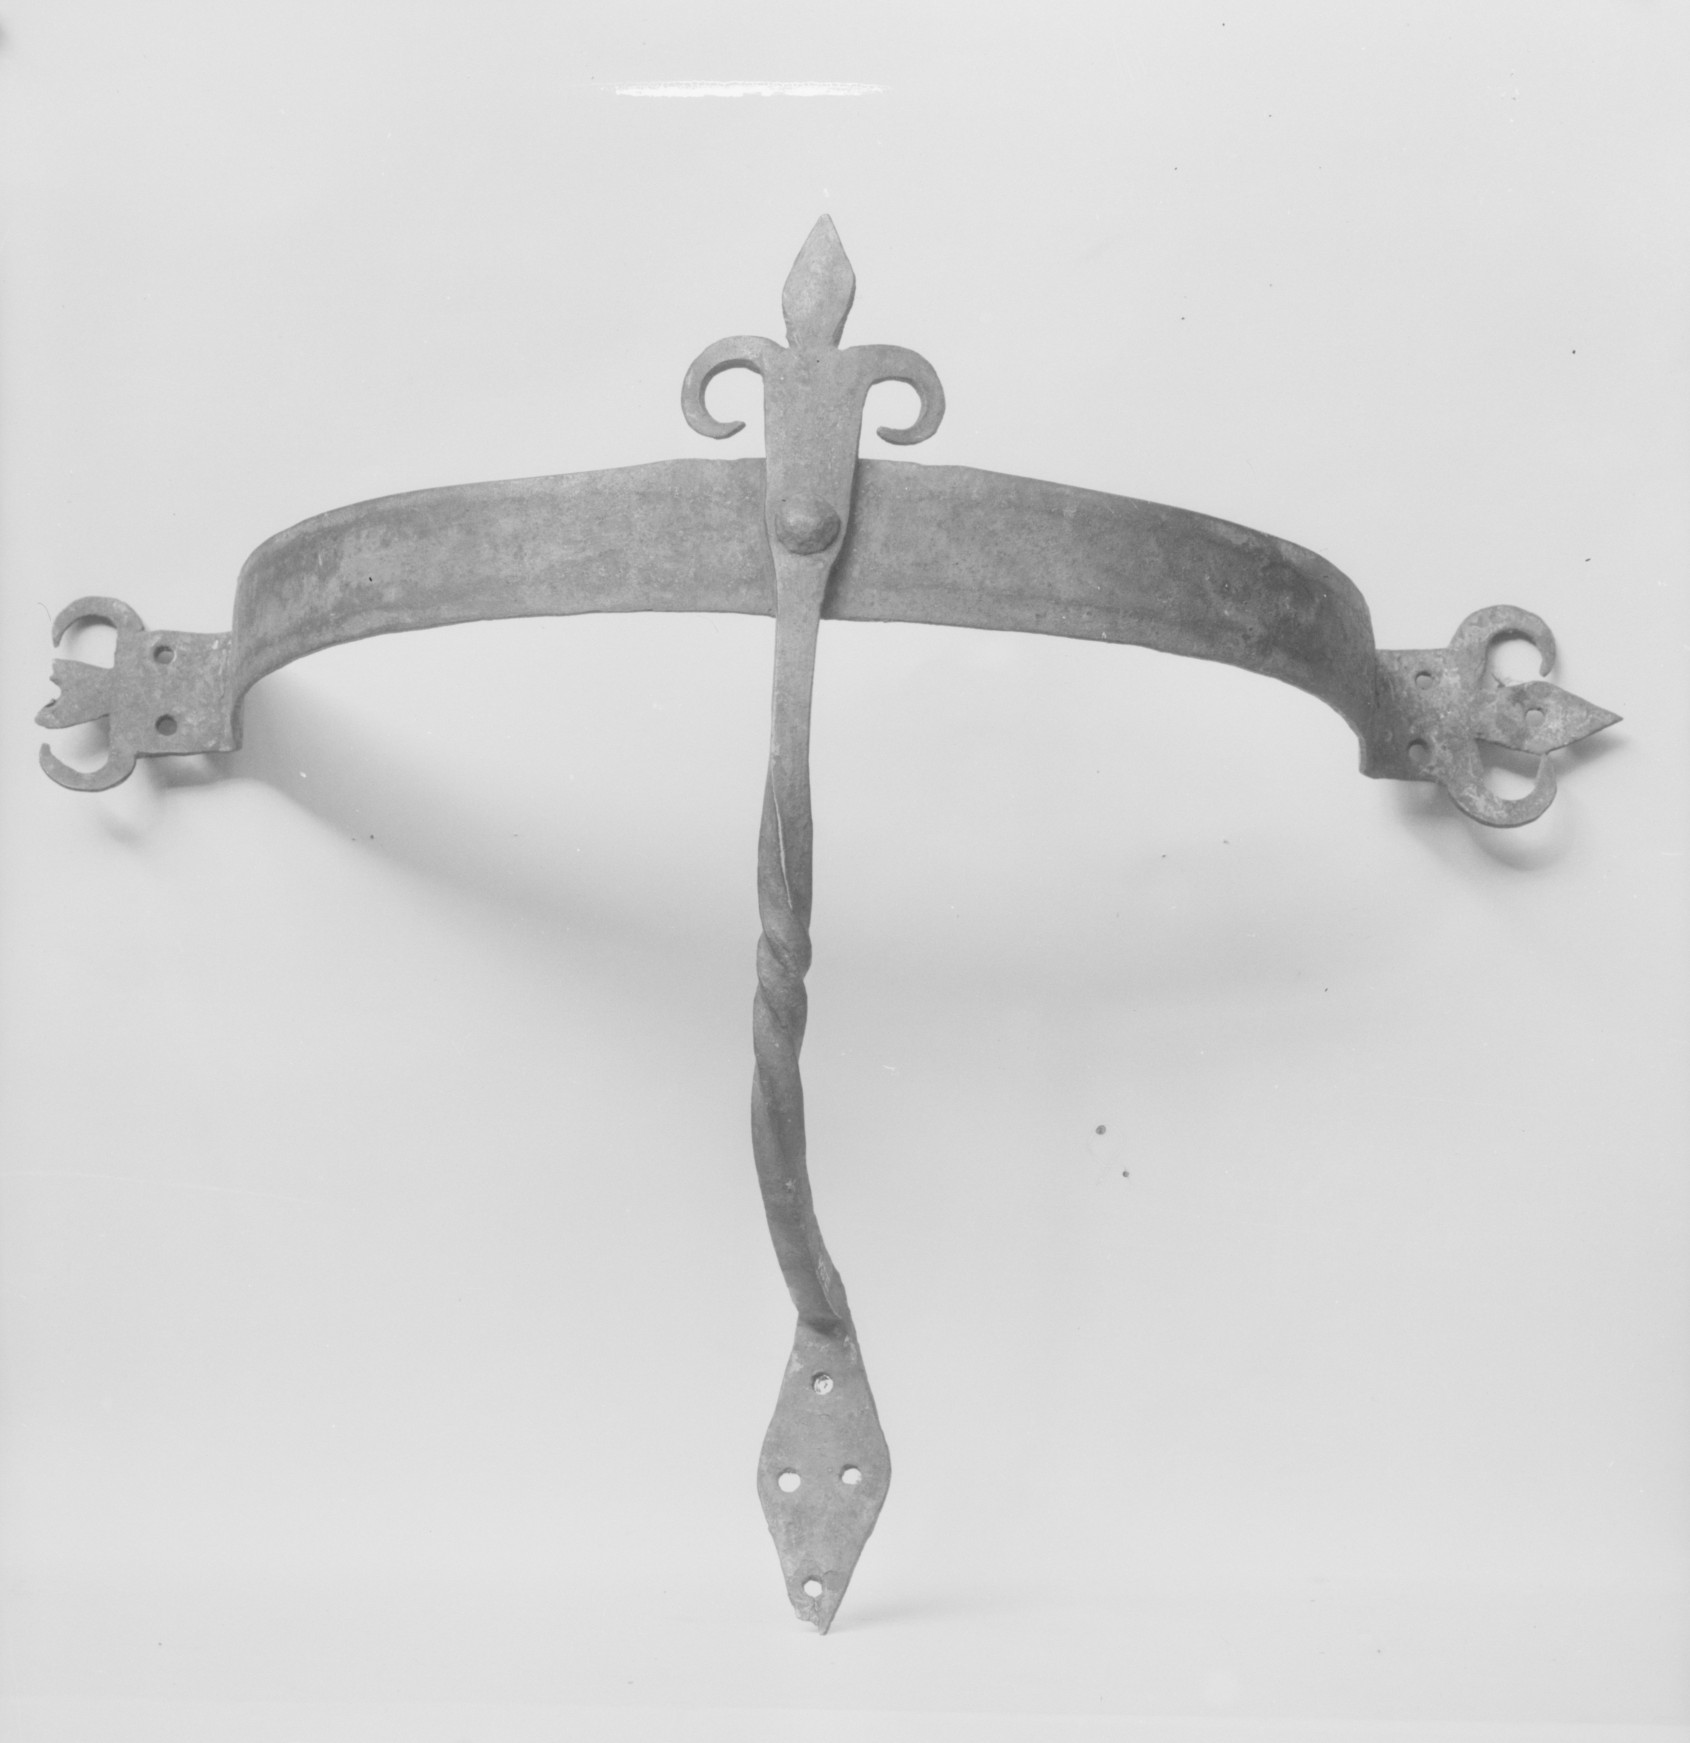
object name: foot scraper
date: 1750-1775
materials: iron